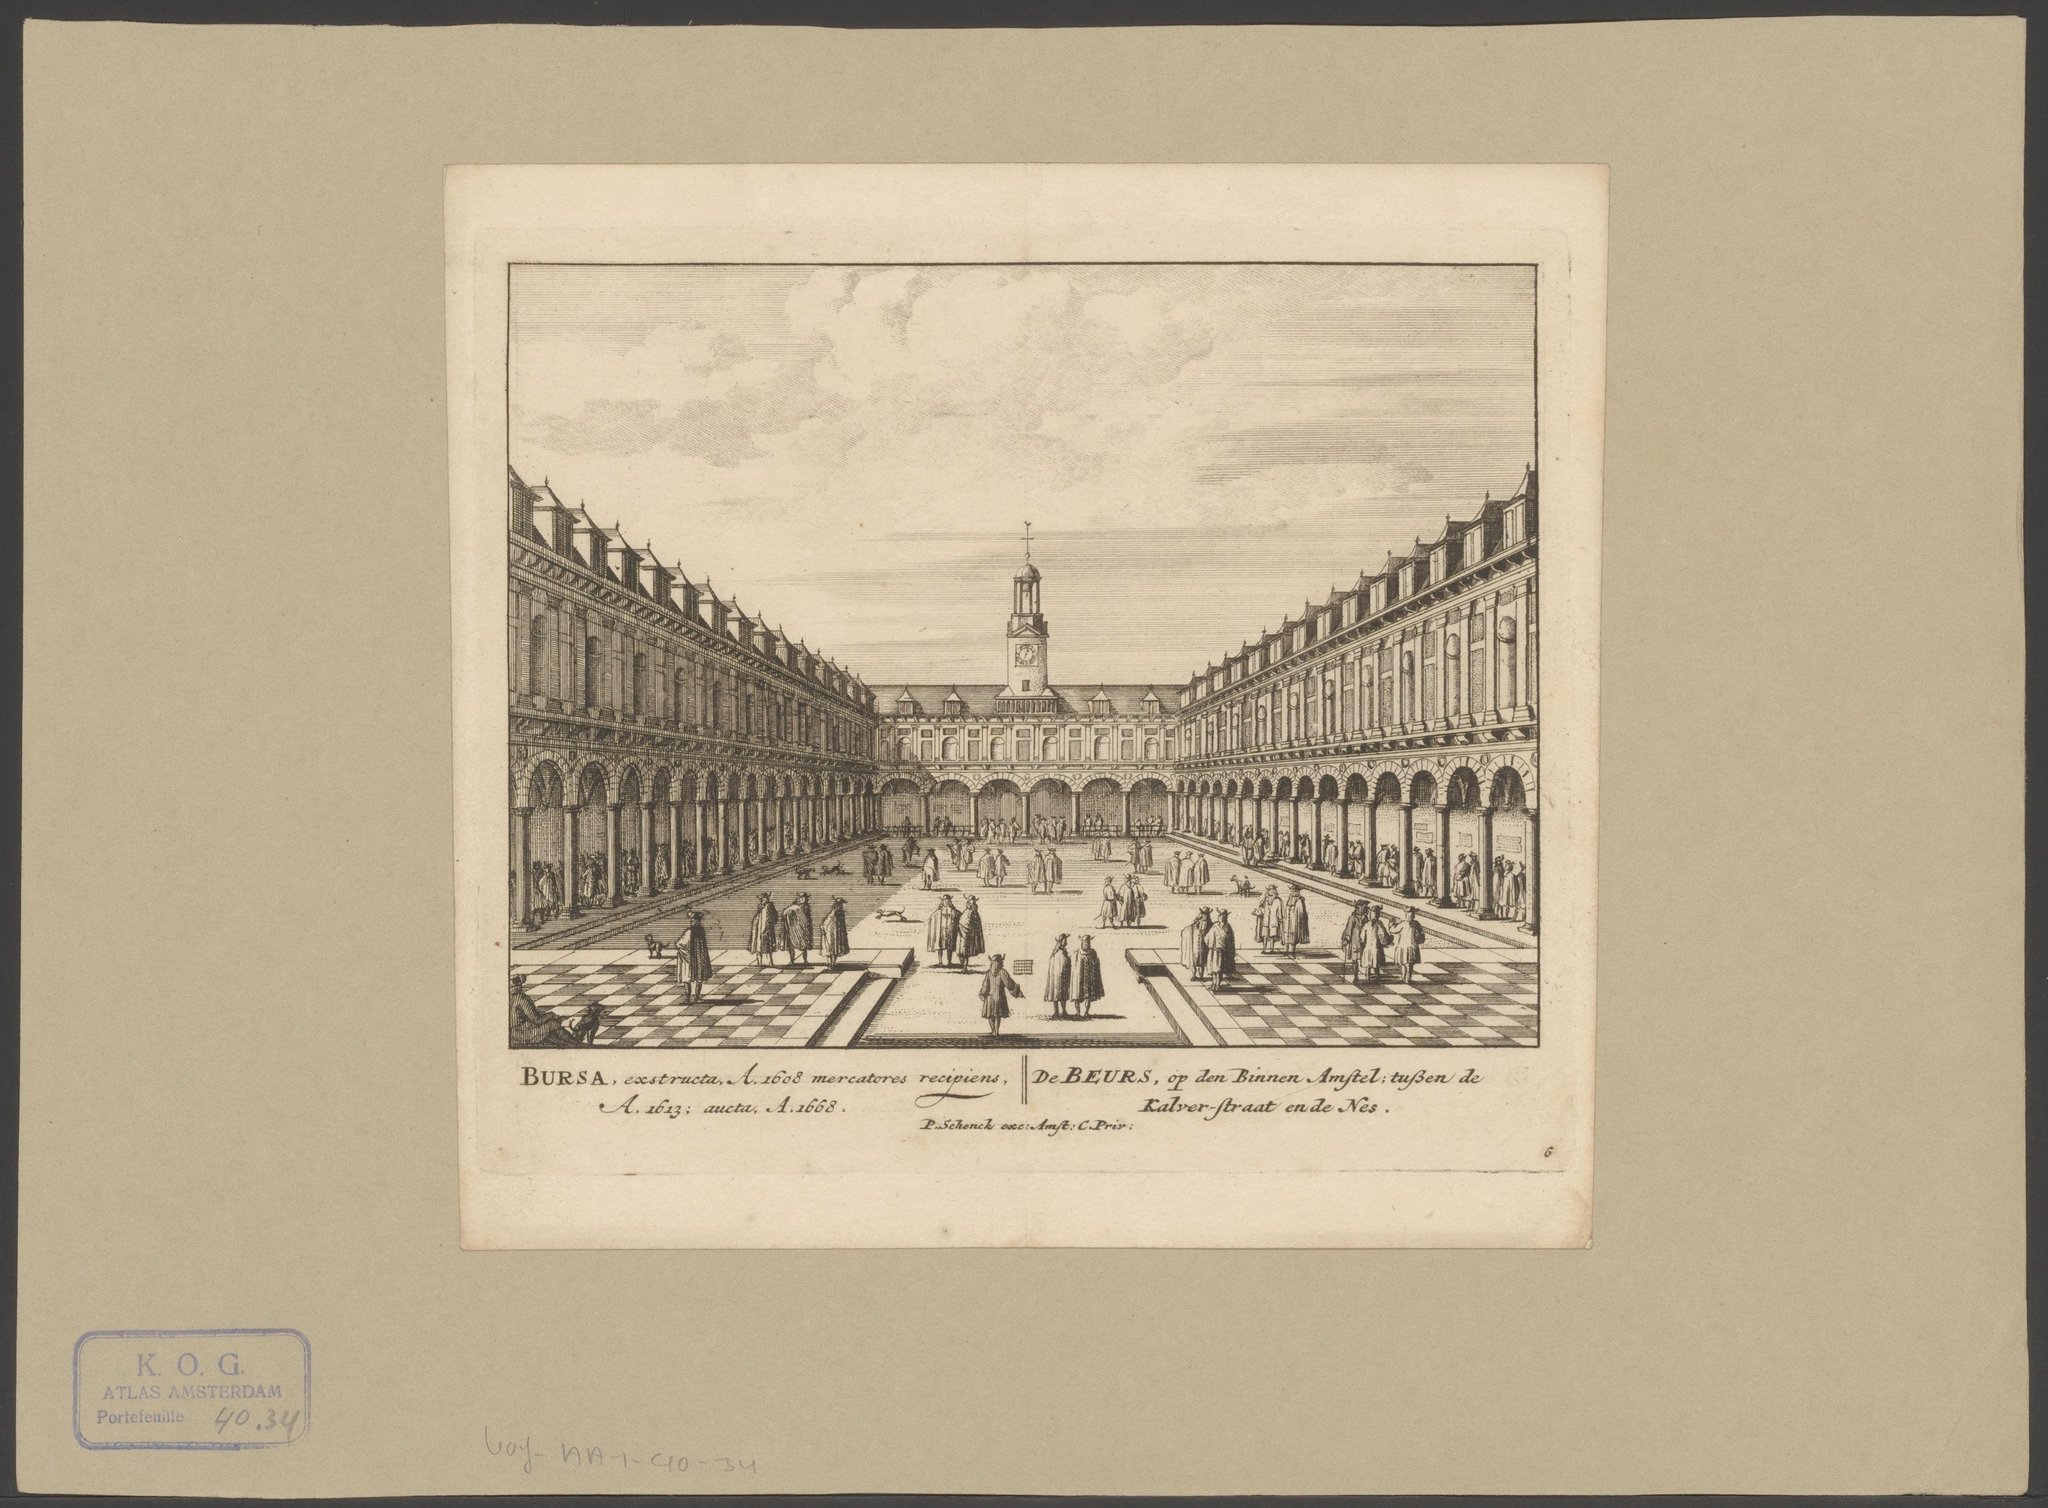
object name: print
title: Bursa, extructa, A. 1608 mercatores recipiens, A. 1613; aucta, A. 1668 / De Beurs, op den Binnen Amstel; tussen de Kalver-straat en de Nes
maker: Anonymous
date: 1710-1711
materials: paper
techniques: engraving, etching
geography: northern netherlands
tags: stock exchange, stock-market, courtyard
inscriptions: collector's mark: Lugt 1641b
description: Prent mogelijk uit: 100 Afbeeldinge der voornaamste gebouwen van Amsterdam. Amsterdam: Pieter Schenk (I), s.a. [1710-1711]. Of uit: 100 Afbeeldinge der voornaamste gebouwen van Amsterdam. Amsterdam: Barent Greve, s.a. [1757-1766]. In de tweede uitgave, uitgegeven door Barent Greve, is alleen de titelprent aangepast. De overige prenten zijn onveranderd gebleven.